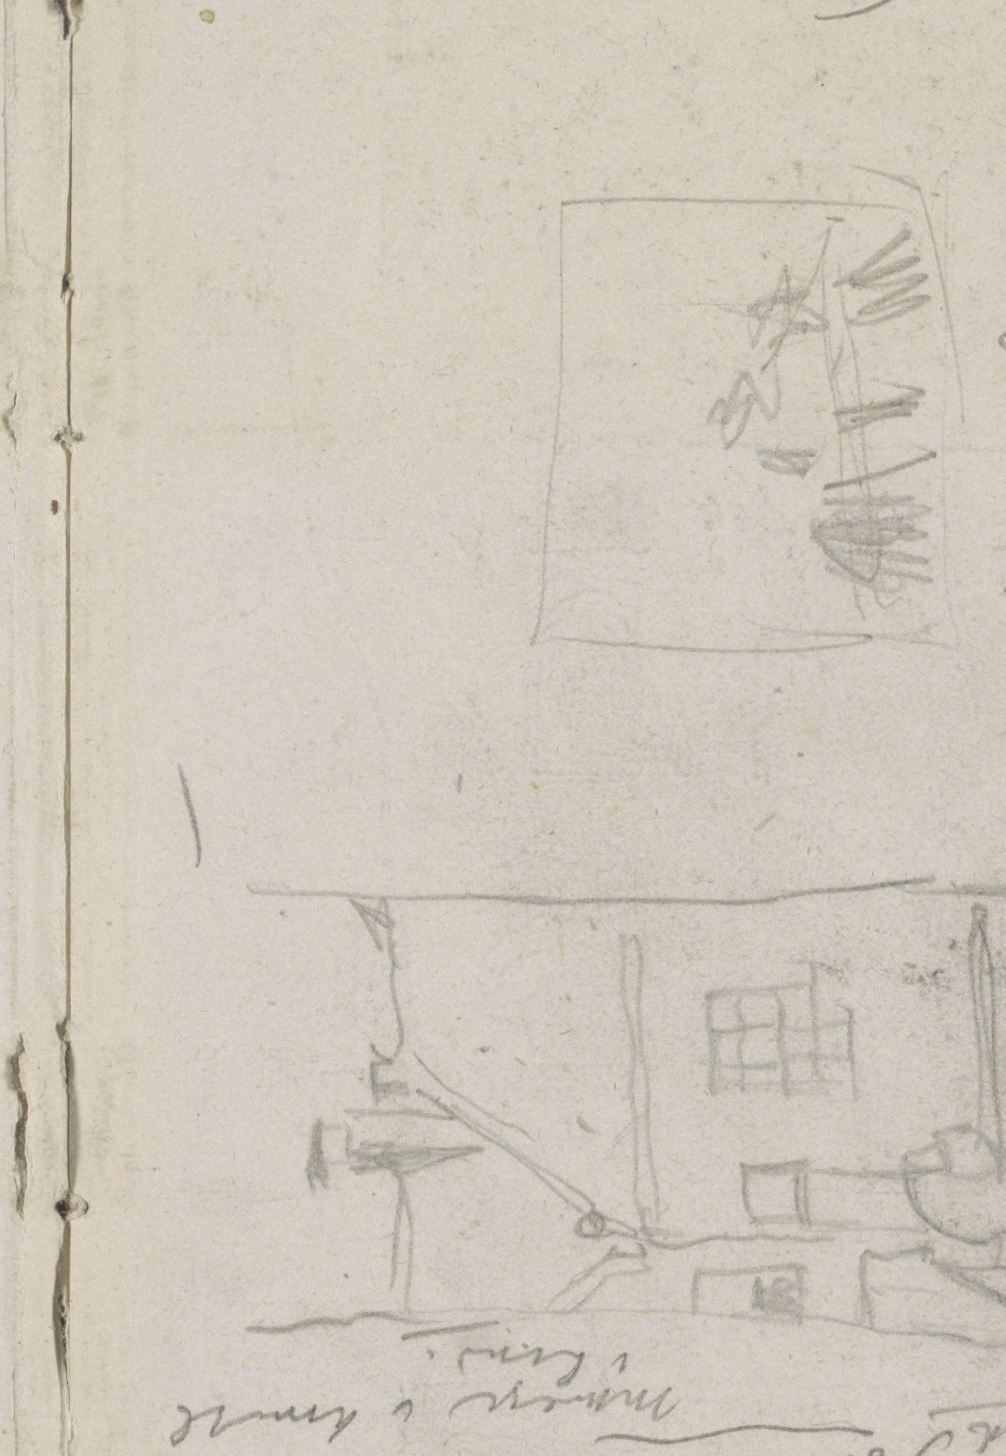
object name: sketchbook leaf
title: Gezicht op een straat in Amsterdam, mogelijk de Driehoekstraat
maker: george hendrik breitner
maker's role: draughtsman, painter, print maker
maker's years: 1857-1923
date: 1902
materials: paper, pencil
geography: amsterdam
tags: urban housing, street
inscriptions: size, annotation: ‘24[...] Witte Brug/ Driehoekstraatje?/ Rokin/Duval/ Van Weij/ [...]/ Yorkshire terrier/ manege/ [...]’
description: Pagina 2 uit een schetsboek met 46 bladen vervaardigd in de omgeving van Amsterdam, Rotterdam en Haarlem.